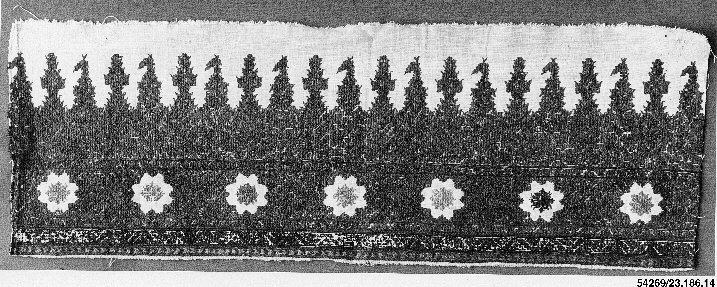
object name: fragment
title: Fragment of Hanging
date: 1801-1833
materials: cotton, silk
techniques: embroidery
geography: morocco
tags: flowers